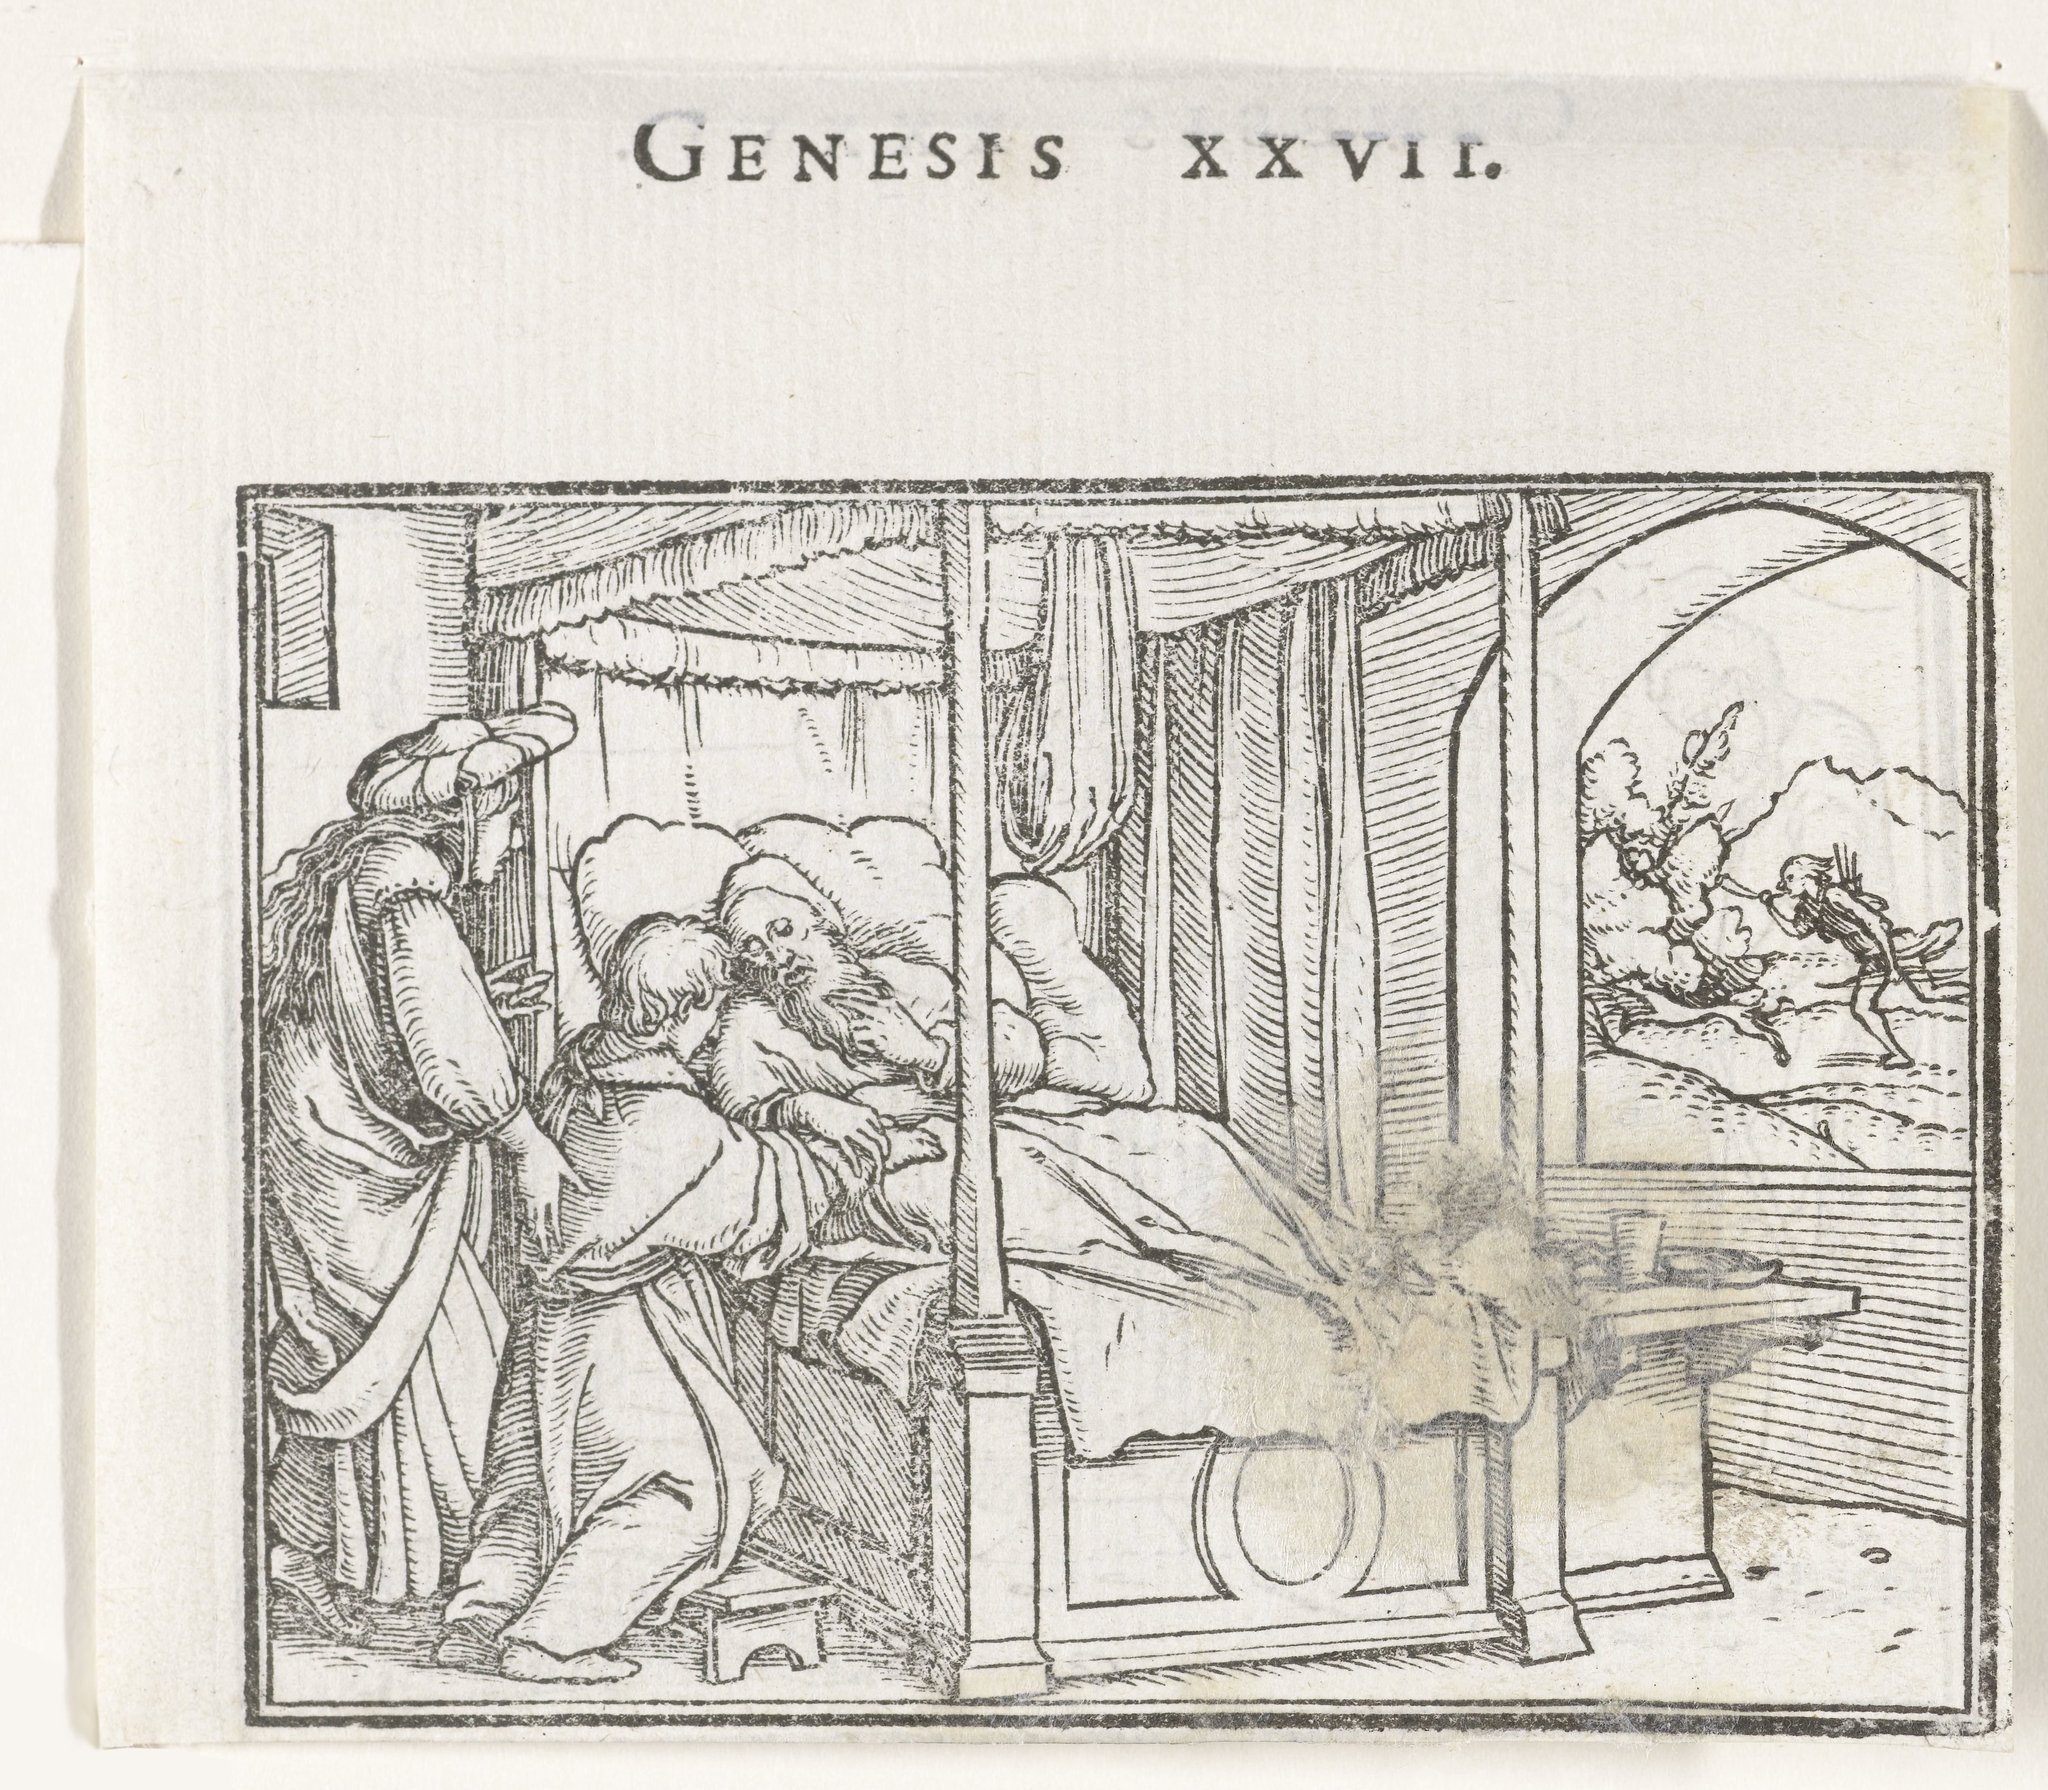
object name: print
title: Isaak zegent Jakob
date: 1538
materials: paper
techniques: woodcut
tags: isaac's blessing (of jacob and esau) (genesis 27)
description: De oude en blinde Isaak ligt in een bed en zegent zijn zoon Jakob. Achter de naast het bed knielende Jakob staat zijn moeder Rebekka. Door het raam is de eerstgeboren zoon Esau met pijl en boog op jacht naar wild zichtbaar. In de marge boven de afbeelding staat de tekst Genesis XXVII.